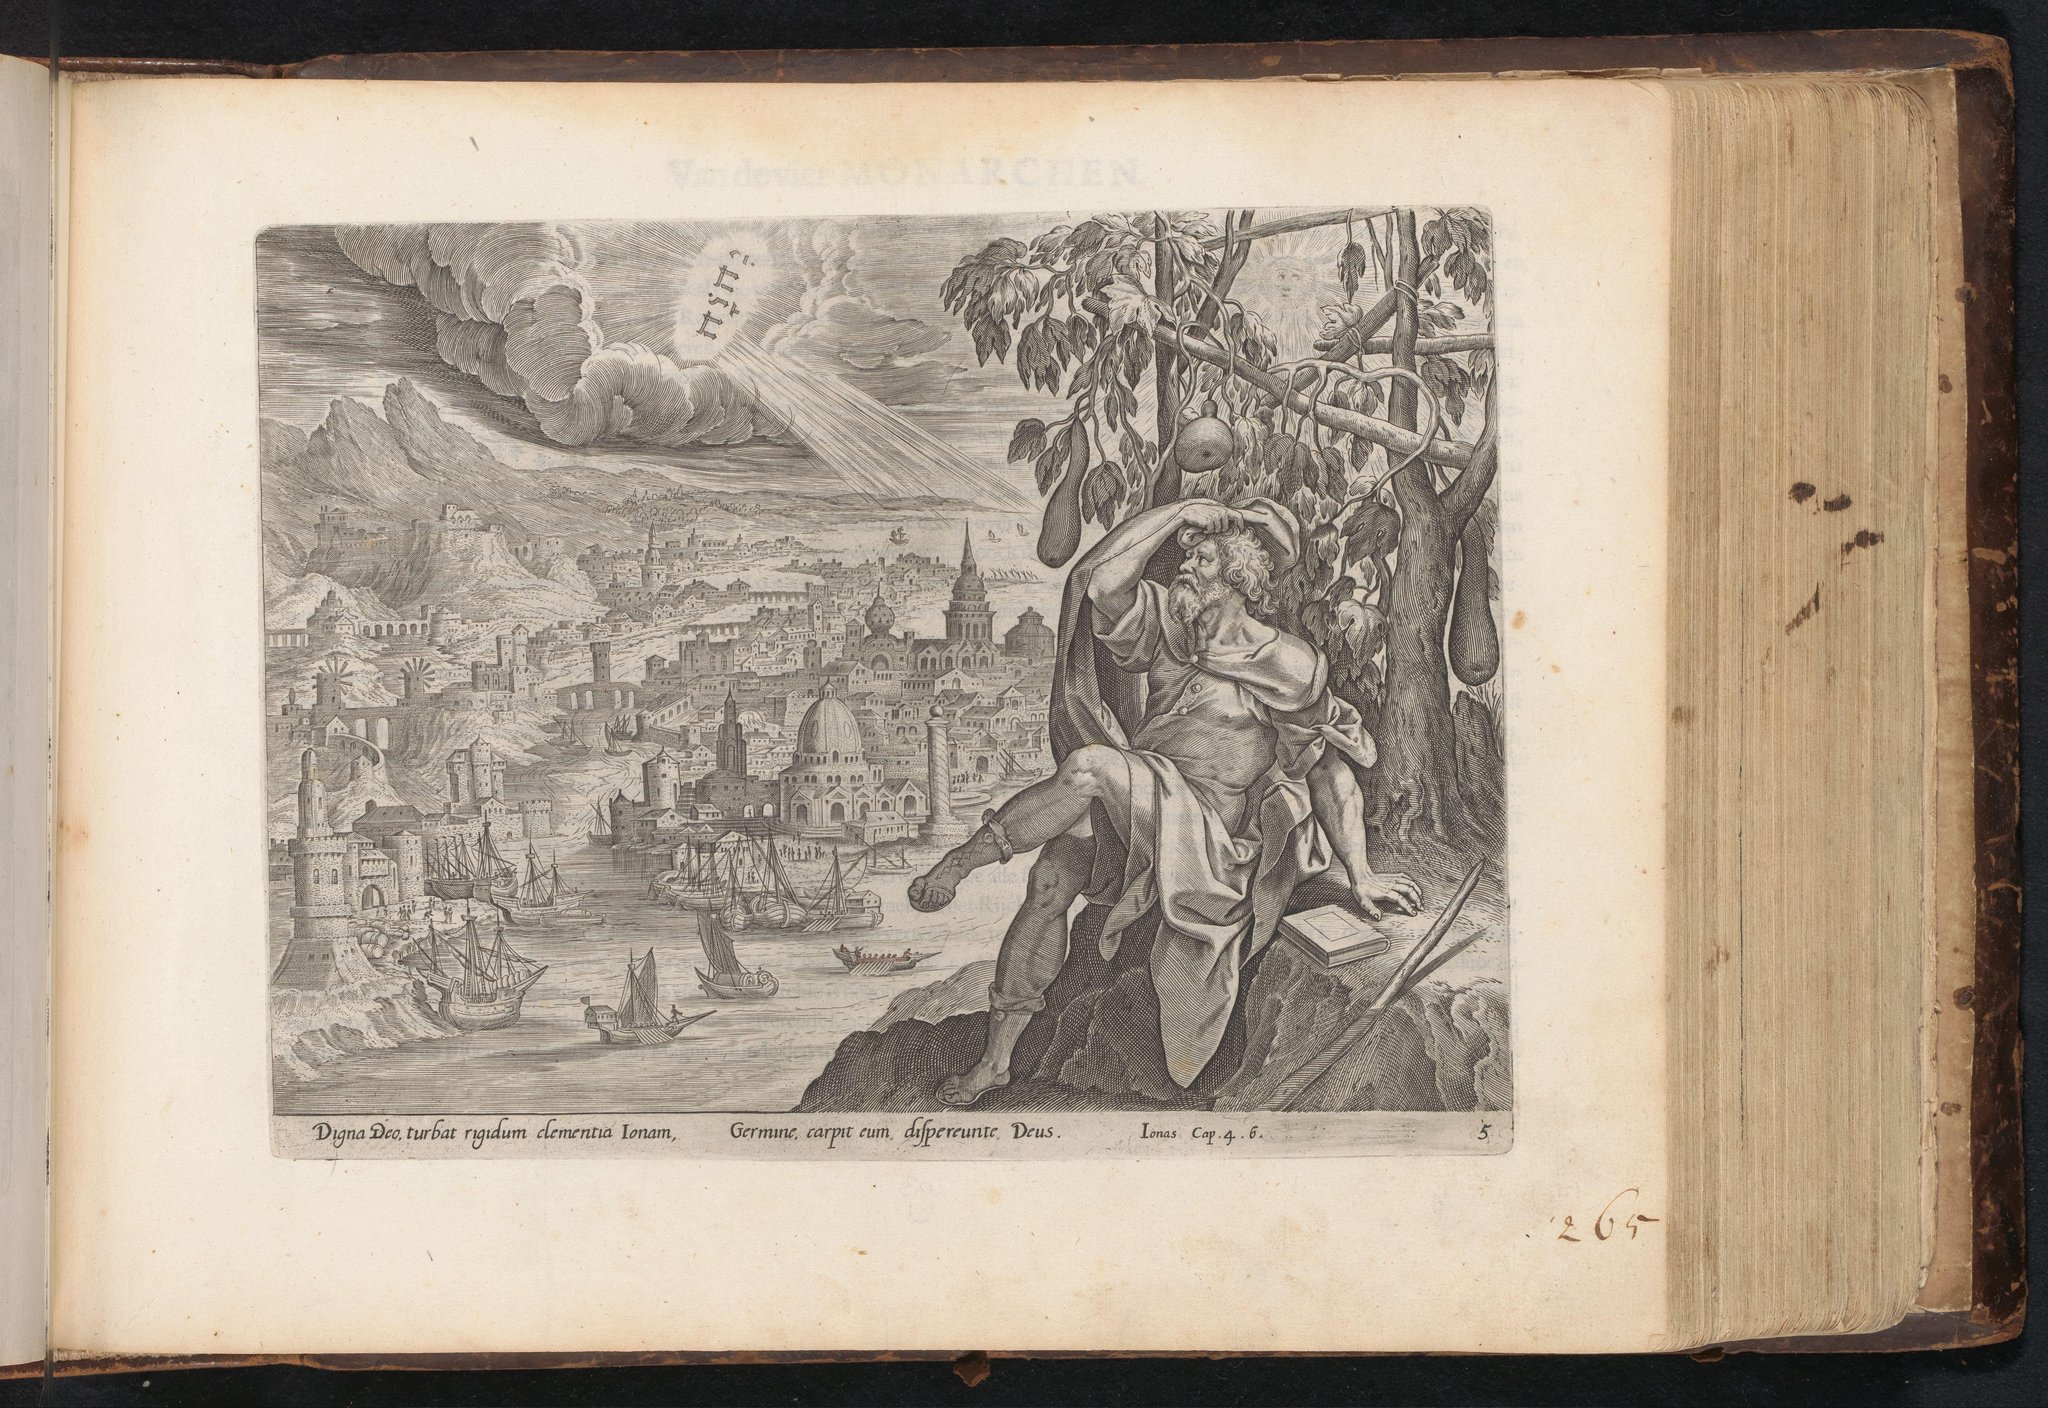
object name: album leaf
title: Den Grooten Figuer-Bibel (...)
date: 1585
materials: paper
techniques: engraving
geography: amsterdam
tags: the gourd (or vine) is eaten by a worm and jonah is exposed to the burning rays of the sun, when jonah again murmurs and wishes to die, god rebukes him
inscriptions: number: ‘265’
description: Jona zit op een rots boven de stad Nineve en wacht tot God de stad zal vernietigen. God heeft een wonderboom voor hem laten groeien, zodat hij in de schaduw kan zitten. Maar de volgende dag is de boom verdord, de bladeren hangen slap, en Jona wordt bevangen door de hitte. Hij houdt zijn mantel boven zijn hoofd tegen de brandende zon. Jona is kwaad over de plant en over het feit dat God de stad niet vernietigd. Hij spreekt erover met God, die in de gedaante van het tetragram op de wolken verschijnt. Onder de voorstelling een verwijzing in het Latijn naar de Bijbeltekst in Jona 4:6. Deze prent maakt deel uit van een album.